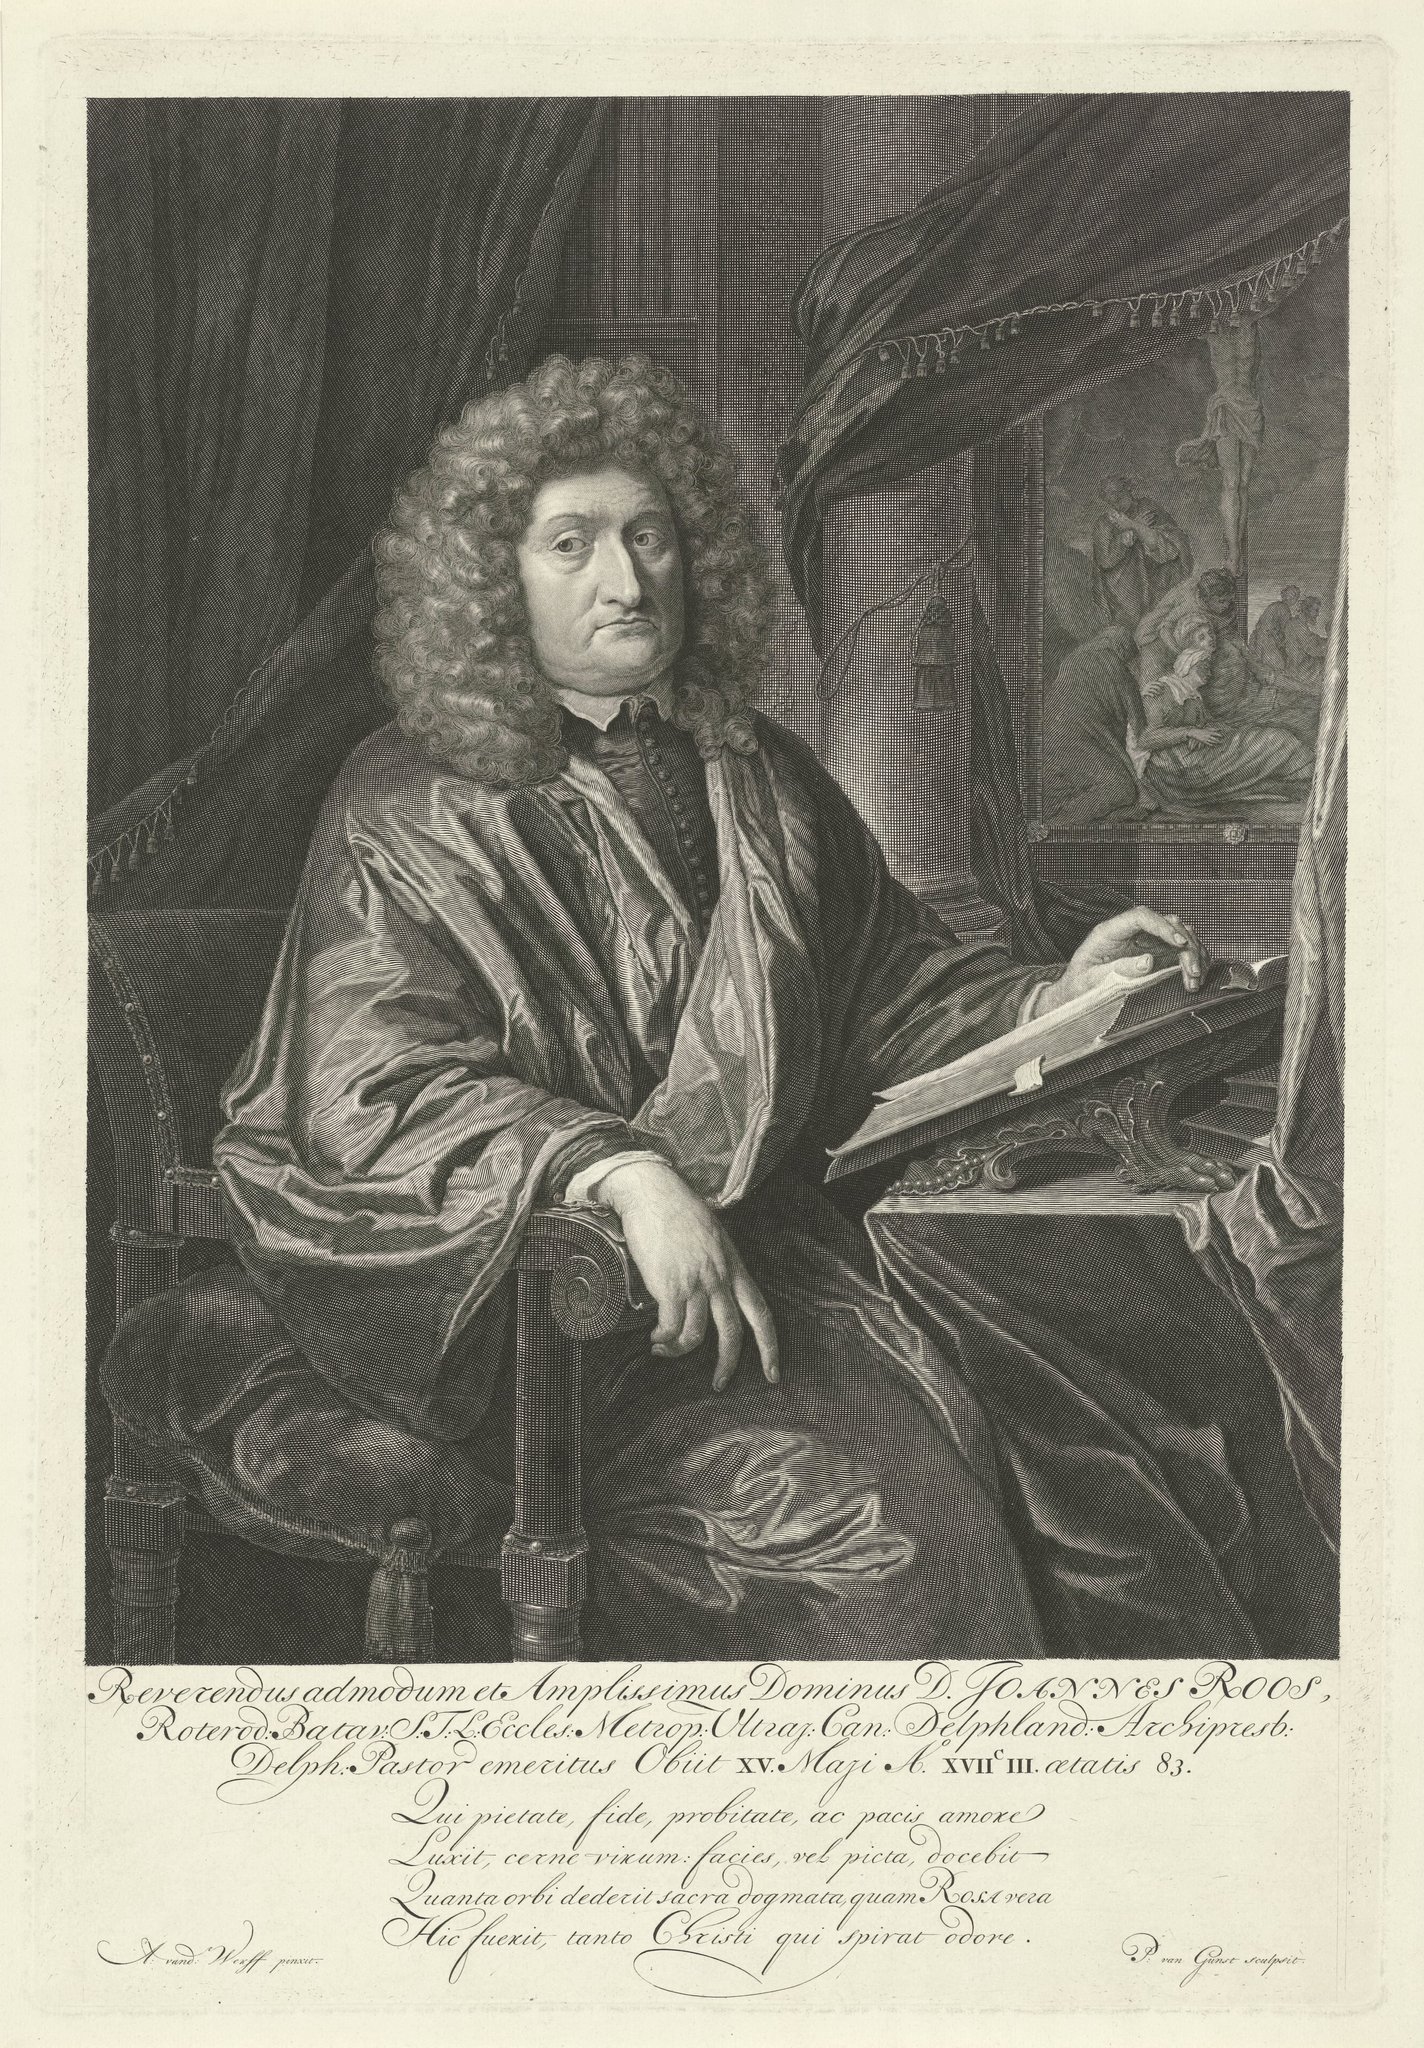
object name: print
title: Portret van Adriaan van Woelwijk alias Johannes Roos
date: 1703-1731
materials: paper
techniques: engraving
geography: amsterdam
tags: crucified christ with other persons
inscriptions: collector's mark: Lugt 2228, collector's mark: Lugt 240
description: Adriaan van Woelwijk alias Johannes Roos, kanunnik te Utrecht. Hij zit voor zijn bureau en leest een boek. Op de achtergrond een schilderij van de kruisiging van Christus. De prent heeft een Latijns onderschrift over zijn leven.